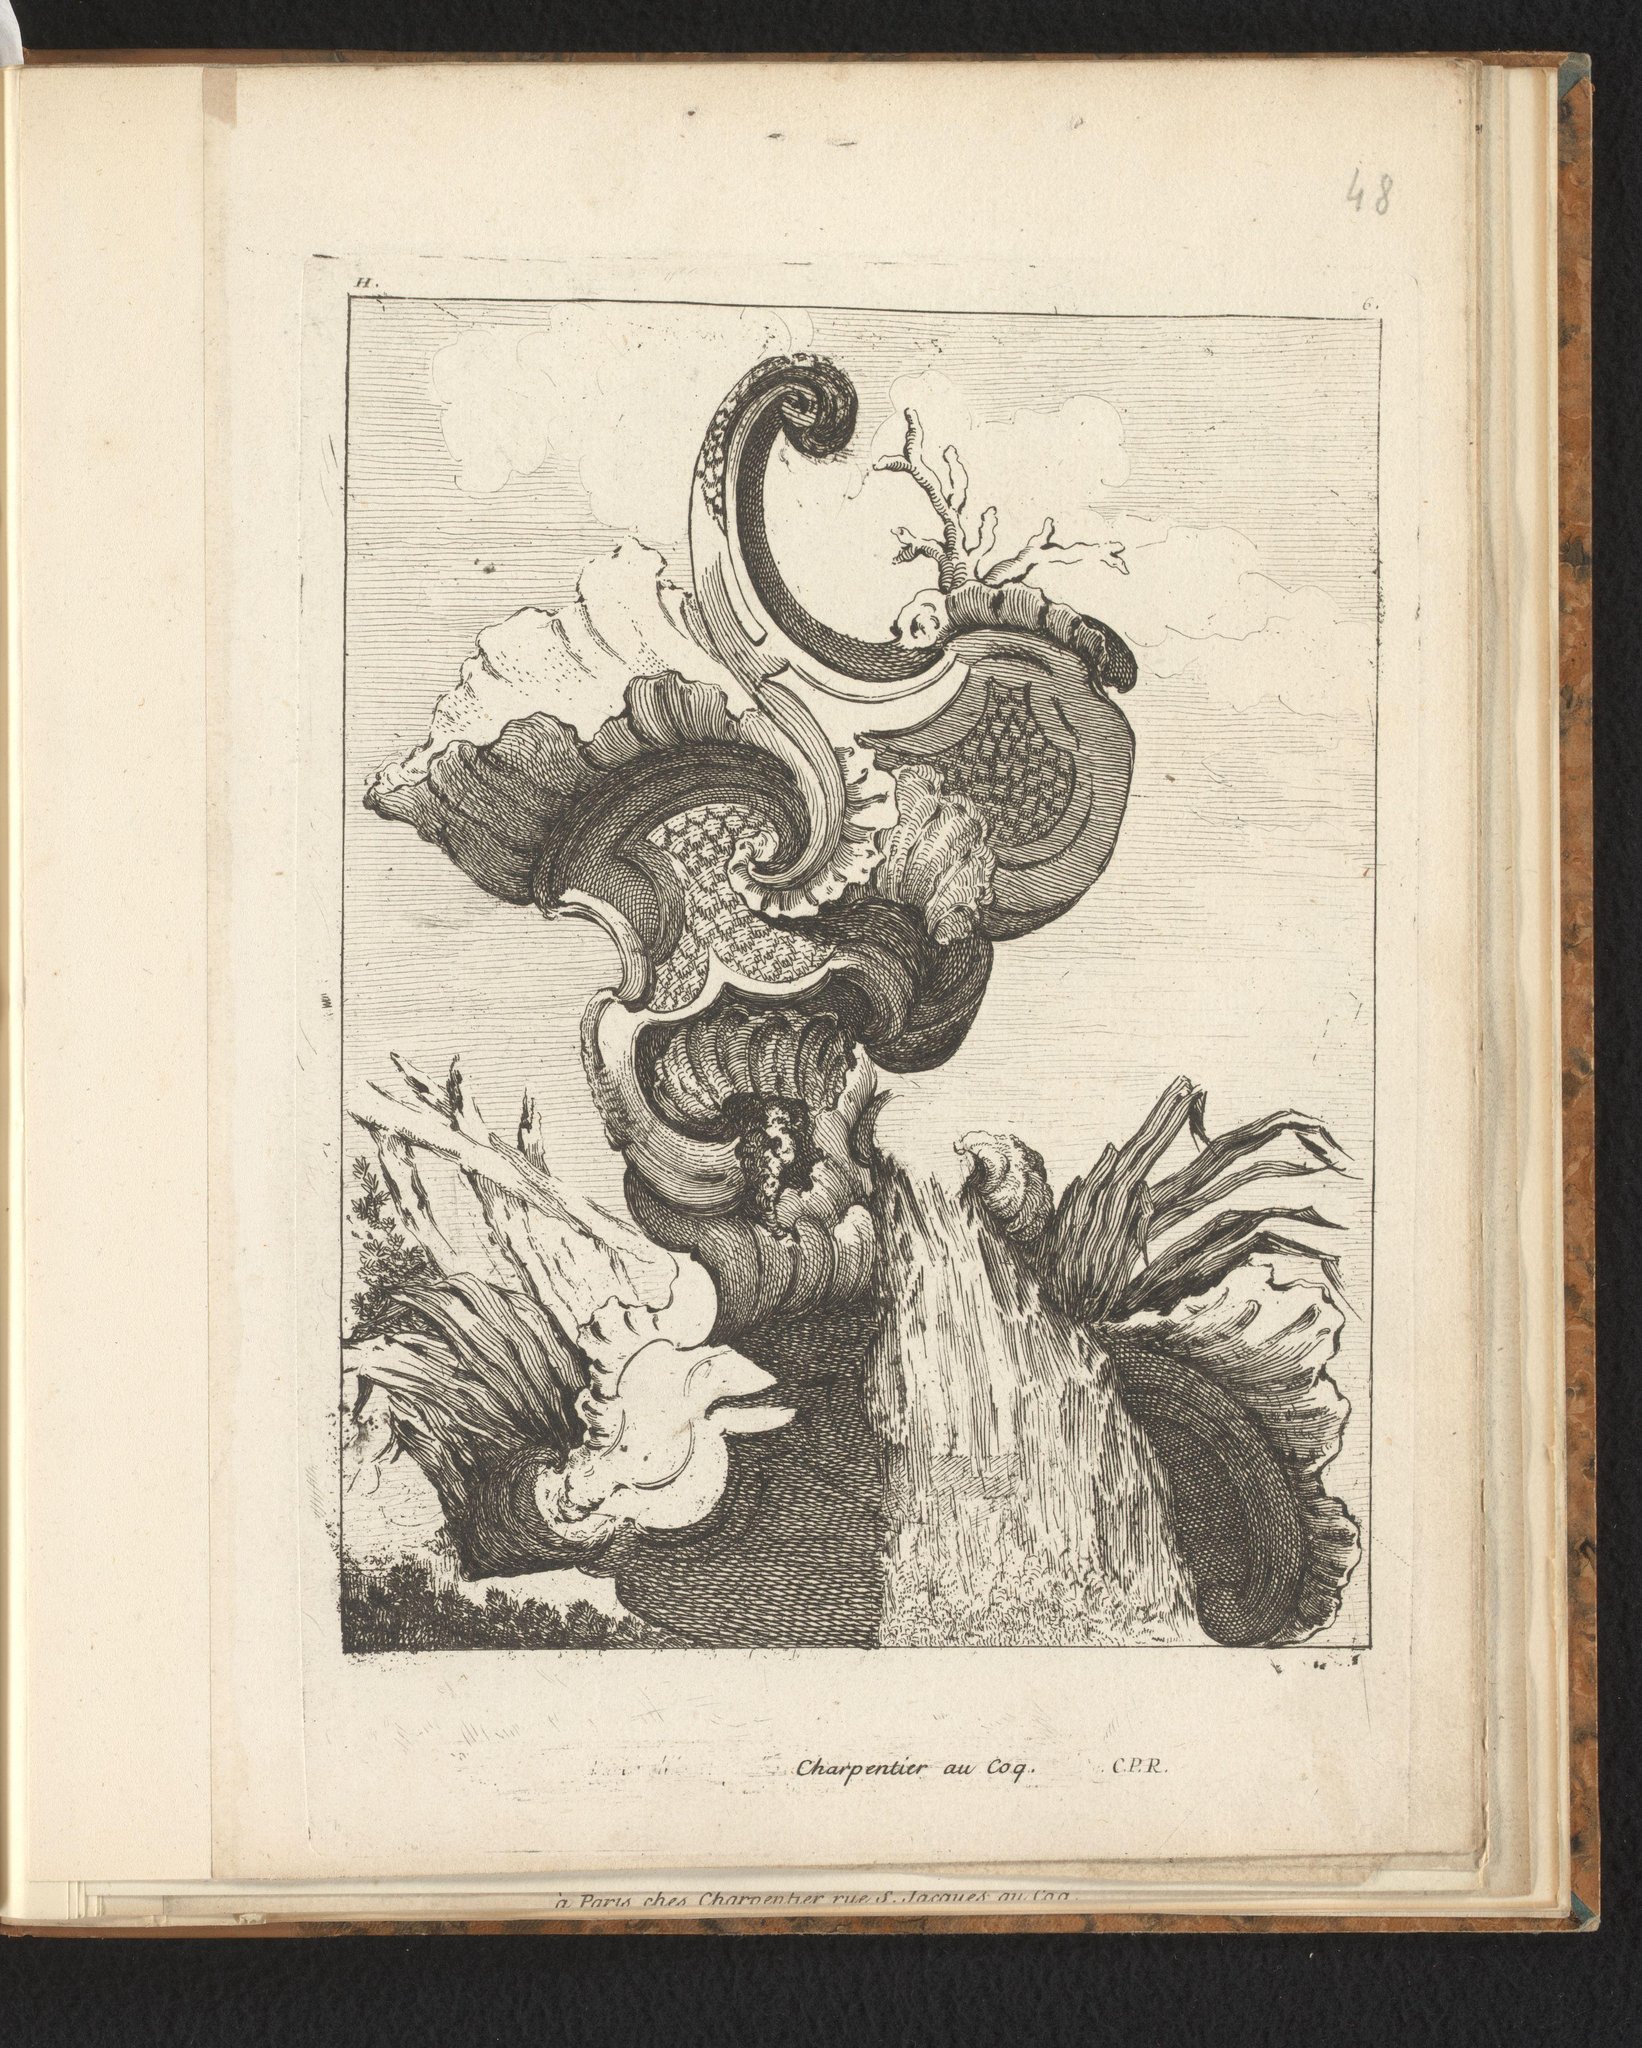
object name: album leaf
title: Serie met rocailles en vazen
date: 1736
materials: paper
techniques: etching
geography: france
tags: rocaille ornament, garden cascade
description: Deze prent maakt deel uit van een serie en is linksboven genummerd met een letter H. Prent maakt deel uit van een album.